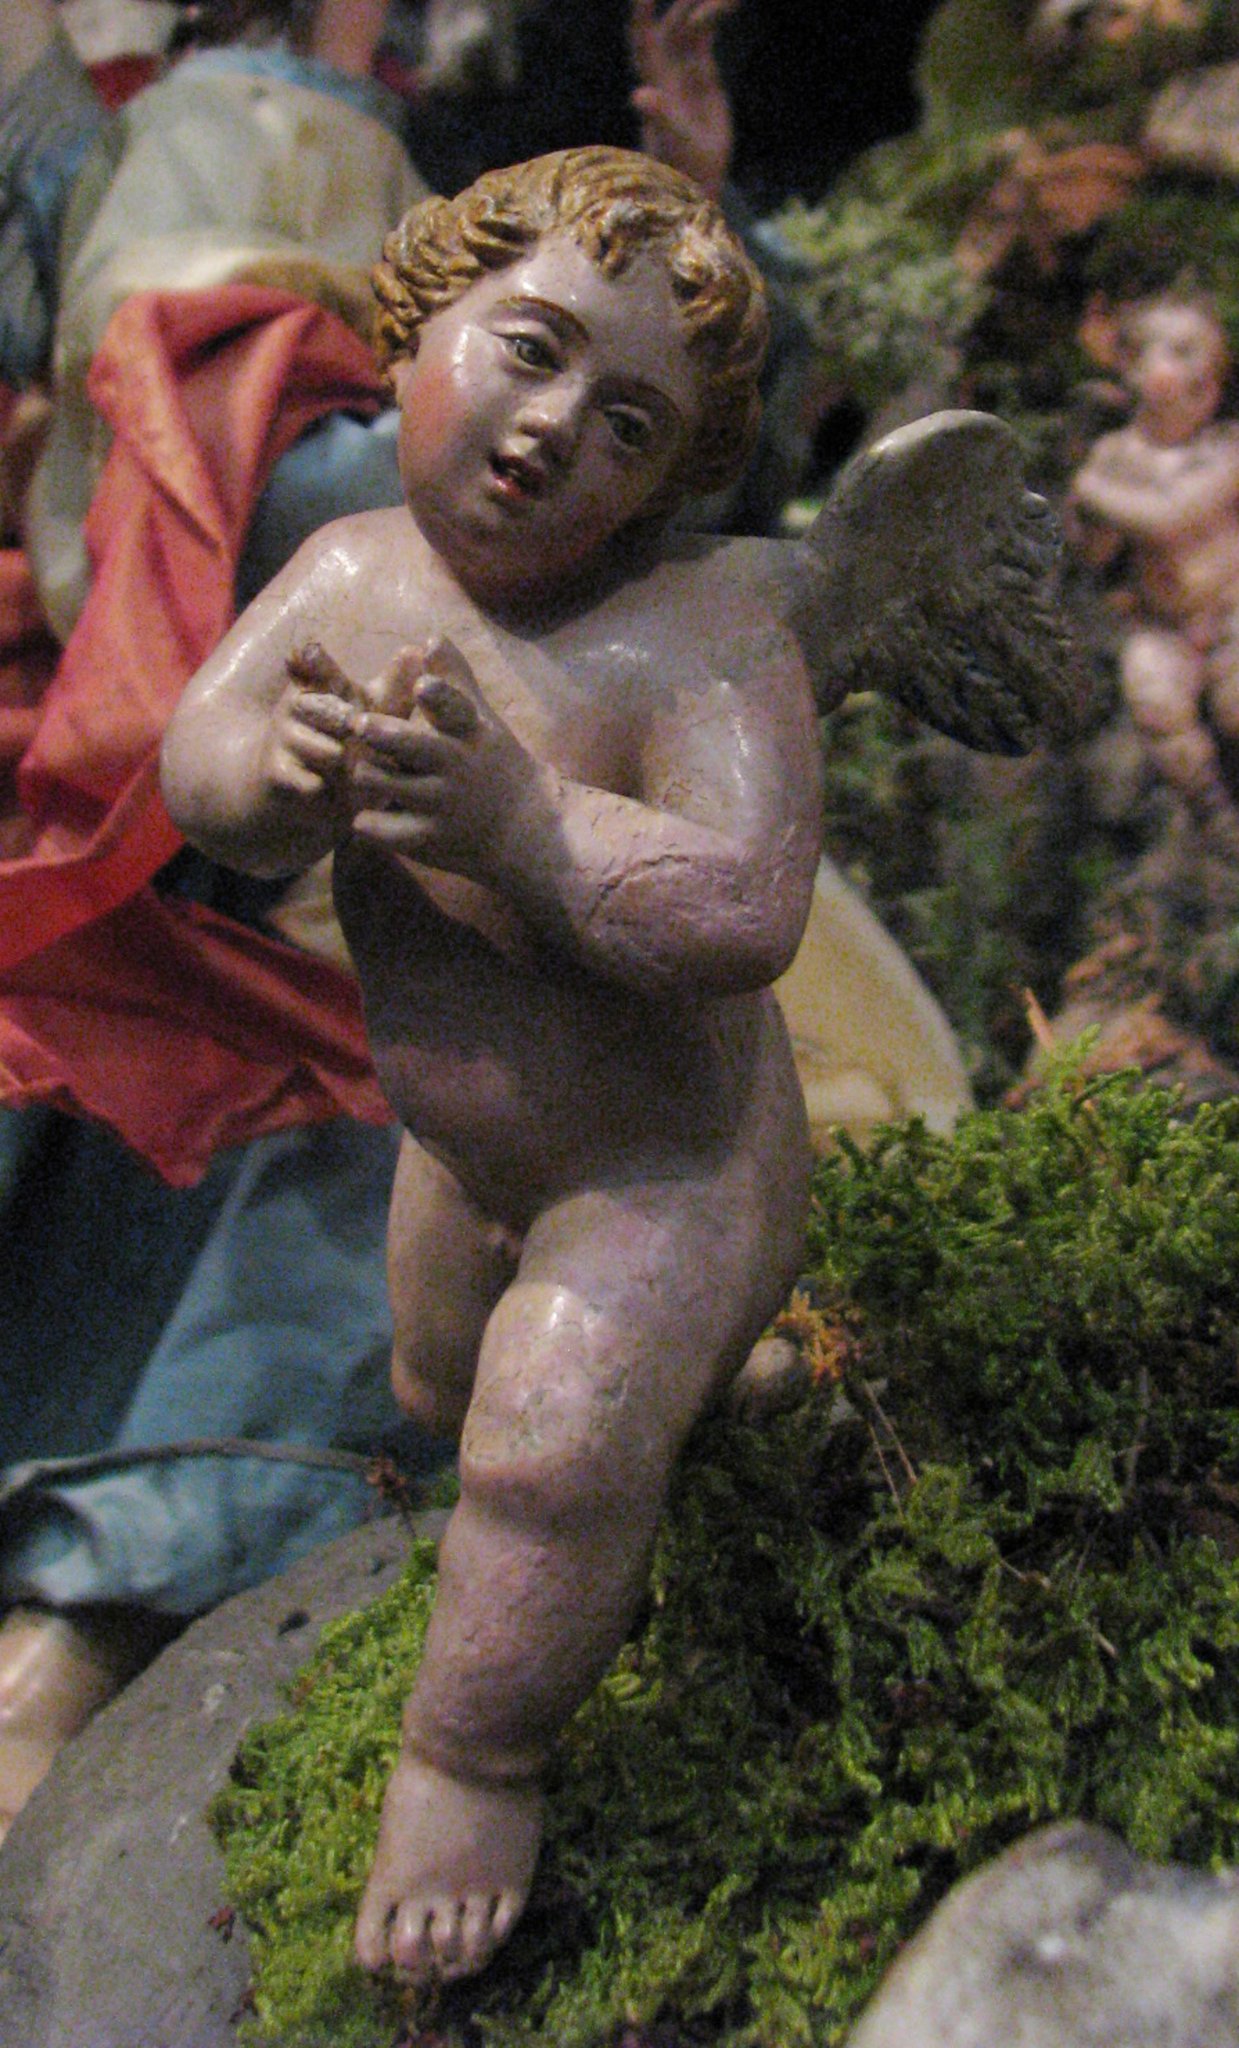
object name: crèche figure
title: Cherub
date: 1751-1800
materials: terracotta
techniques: polychrome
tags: angels